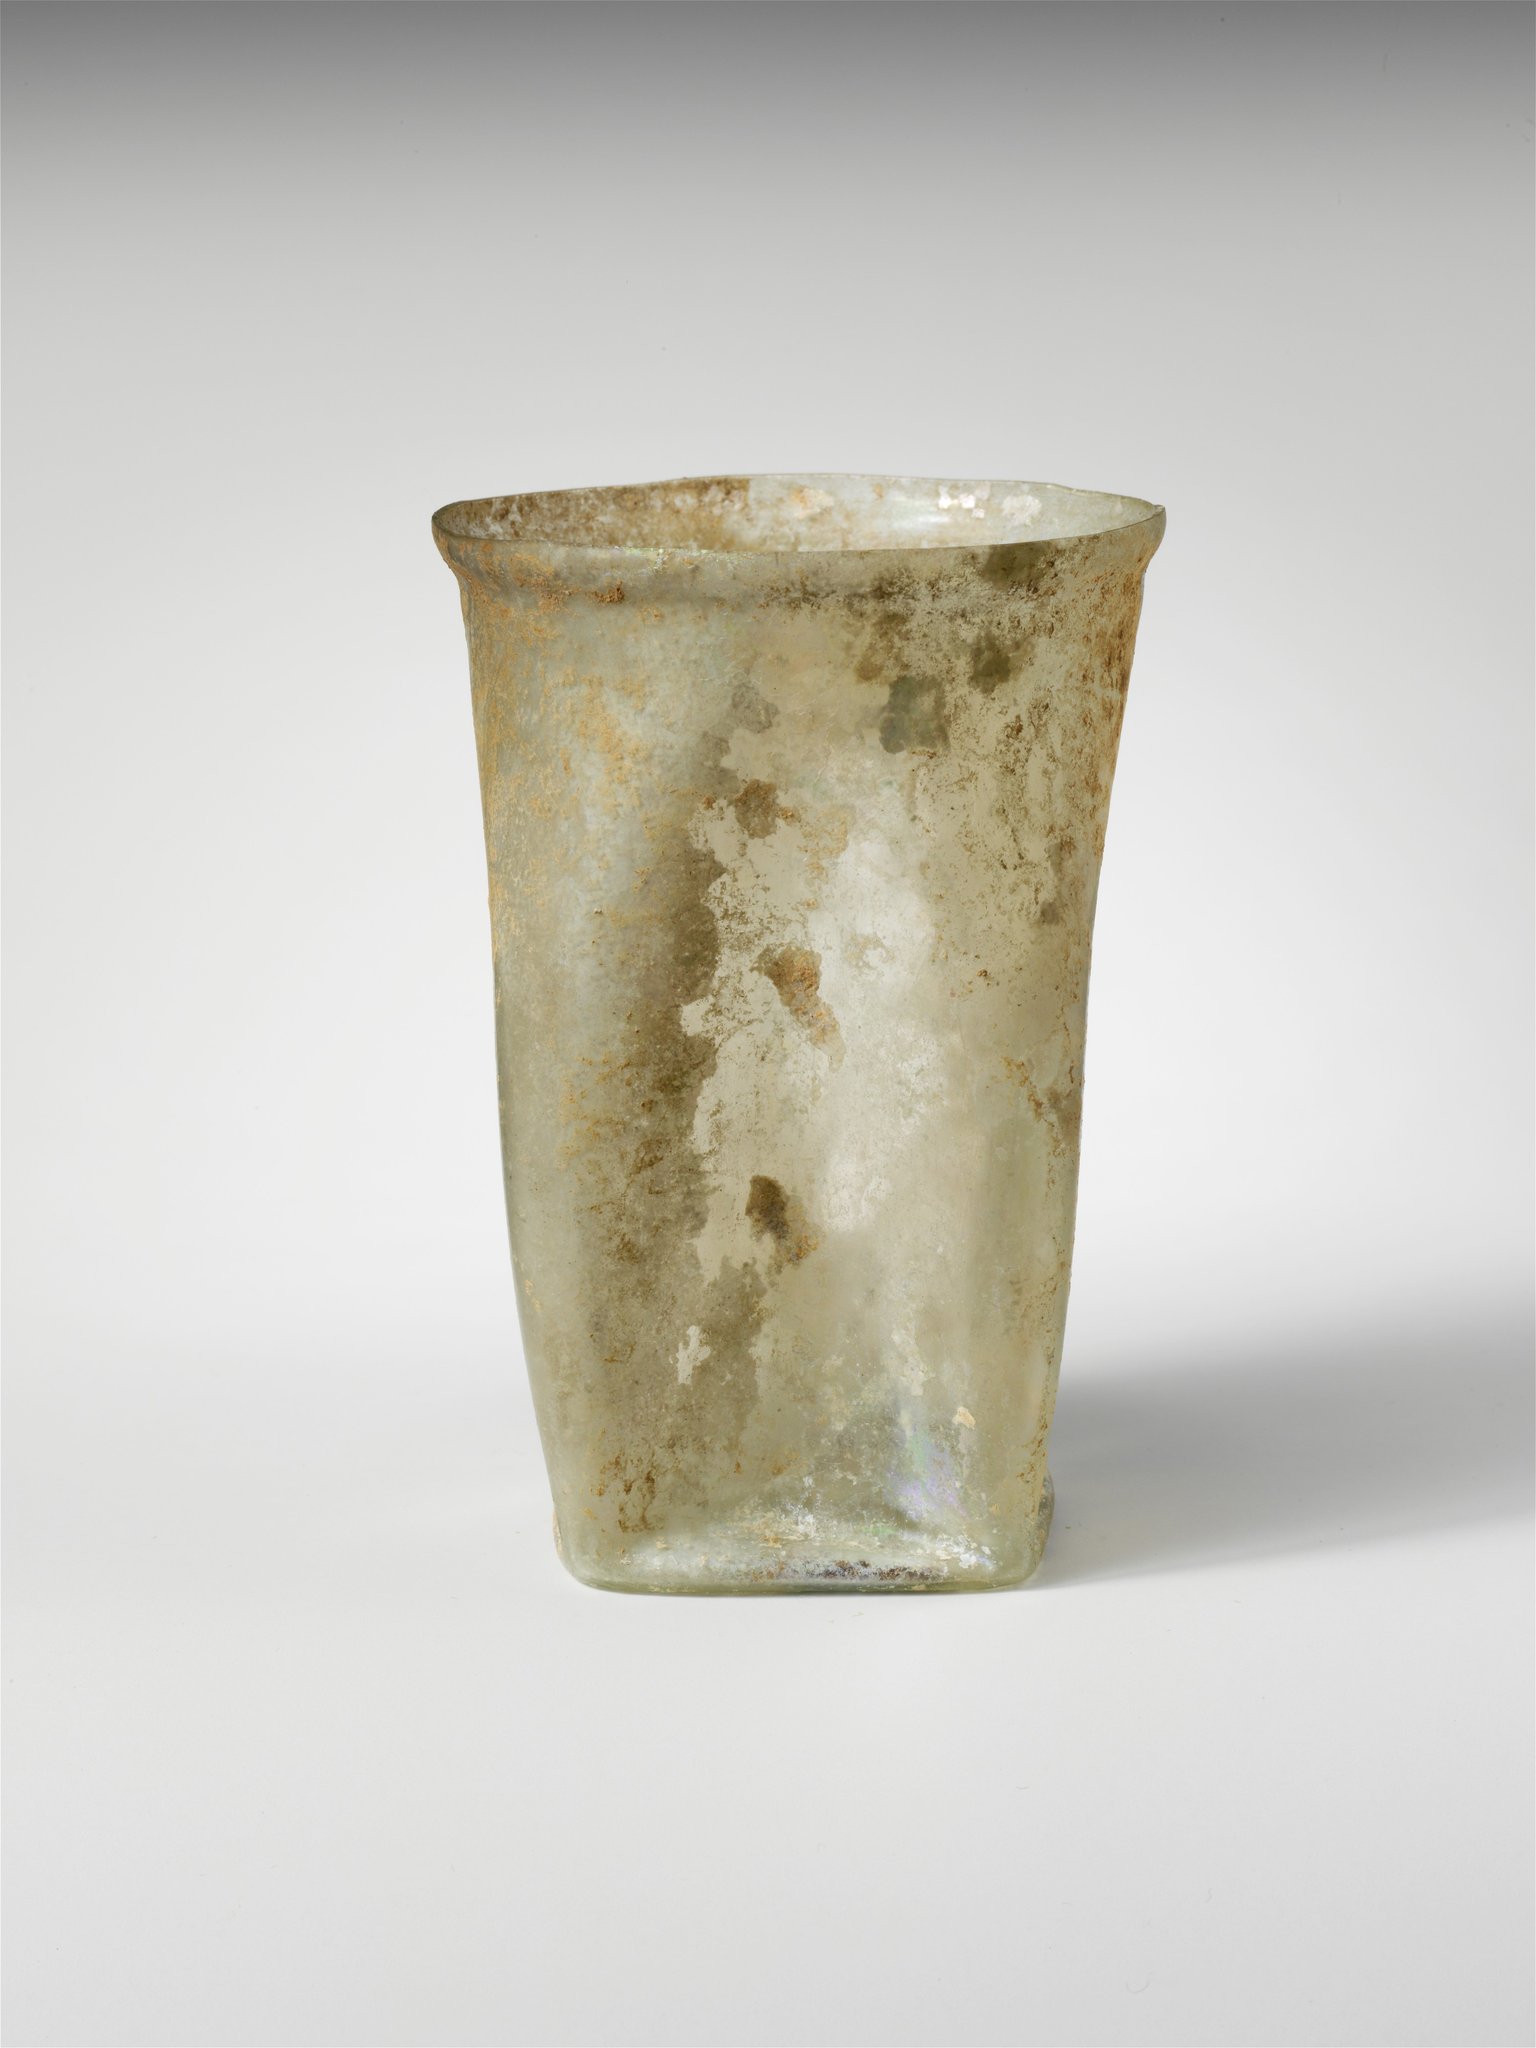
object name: beaker, indented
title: Glass beaker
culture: roman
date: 34-300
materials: glass